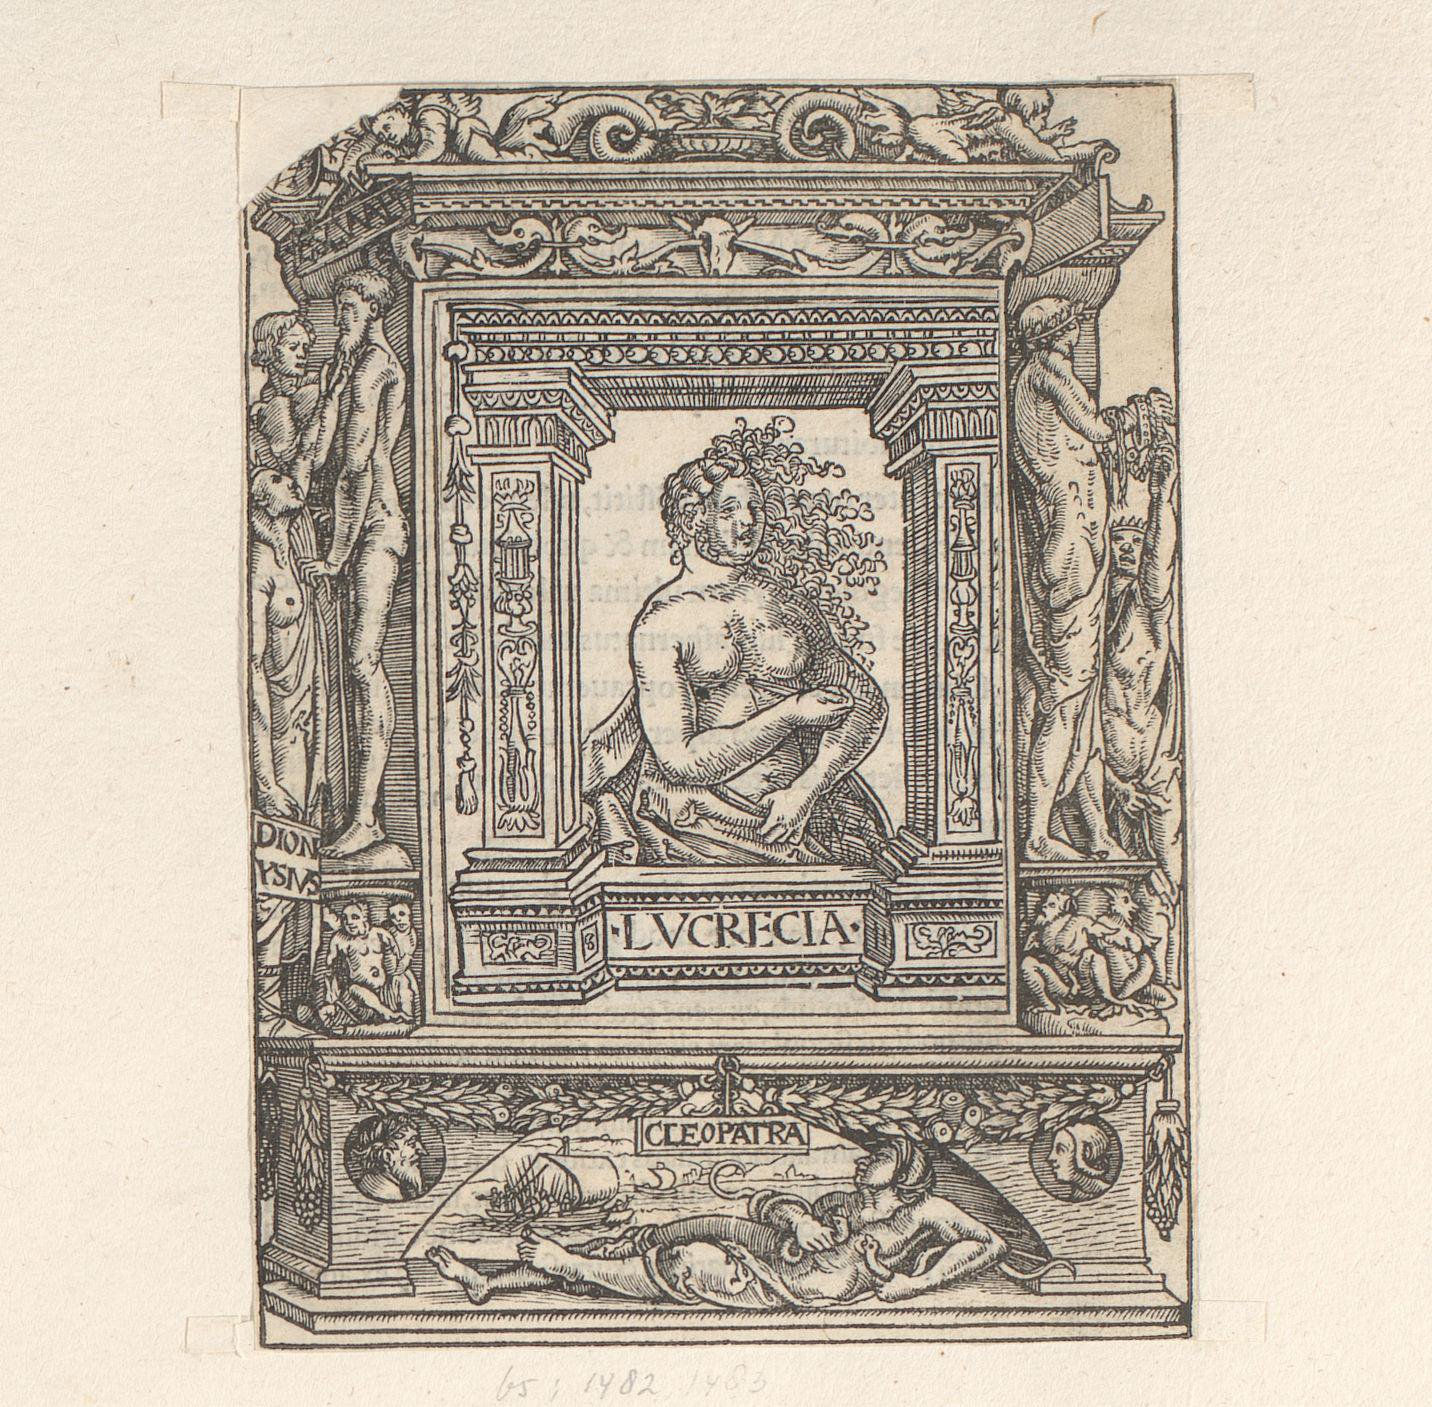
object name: book illustration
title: Dood van Lucretia met in de omlijsting Cleopatra en Dionysius I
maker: Anonymous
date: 1523-1623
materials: paper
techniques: letterpress printing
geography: germany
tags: death of cleopatra: she commits suicide by holding to her breast an asp, which she has taken from a basket of figs, death of lucretia: she commits suicide by stabbing herself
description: Prent met in de omlijsting een opgeplakte prent. In het midden Lucretia, die zichzelf met been dolk in de borst steekt. Rondom een omlijsting met renaissance architectuur in de vorm van een monument. Onder een boog ligt Cleopatra met twee giftige slangen: de dood van Cleopatra. Links en rechts is Dionysius I, tiran van Syracuse, de kostbaarheden van de godenbeelden aan het roven. Rechts houdt hij een schildje vast met daarop zijn naam DIONYSIUS. Bovenop het monument staat een vaas temidden van twee putti zittend op dolfijnen. Prent maakt deel uit van een album.